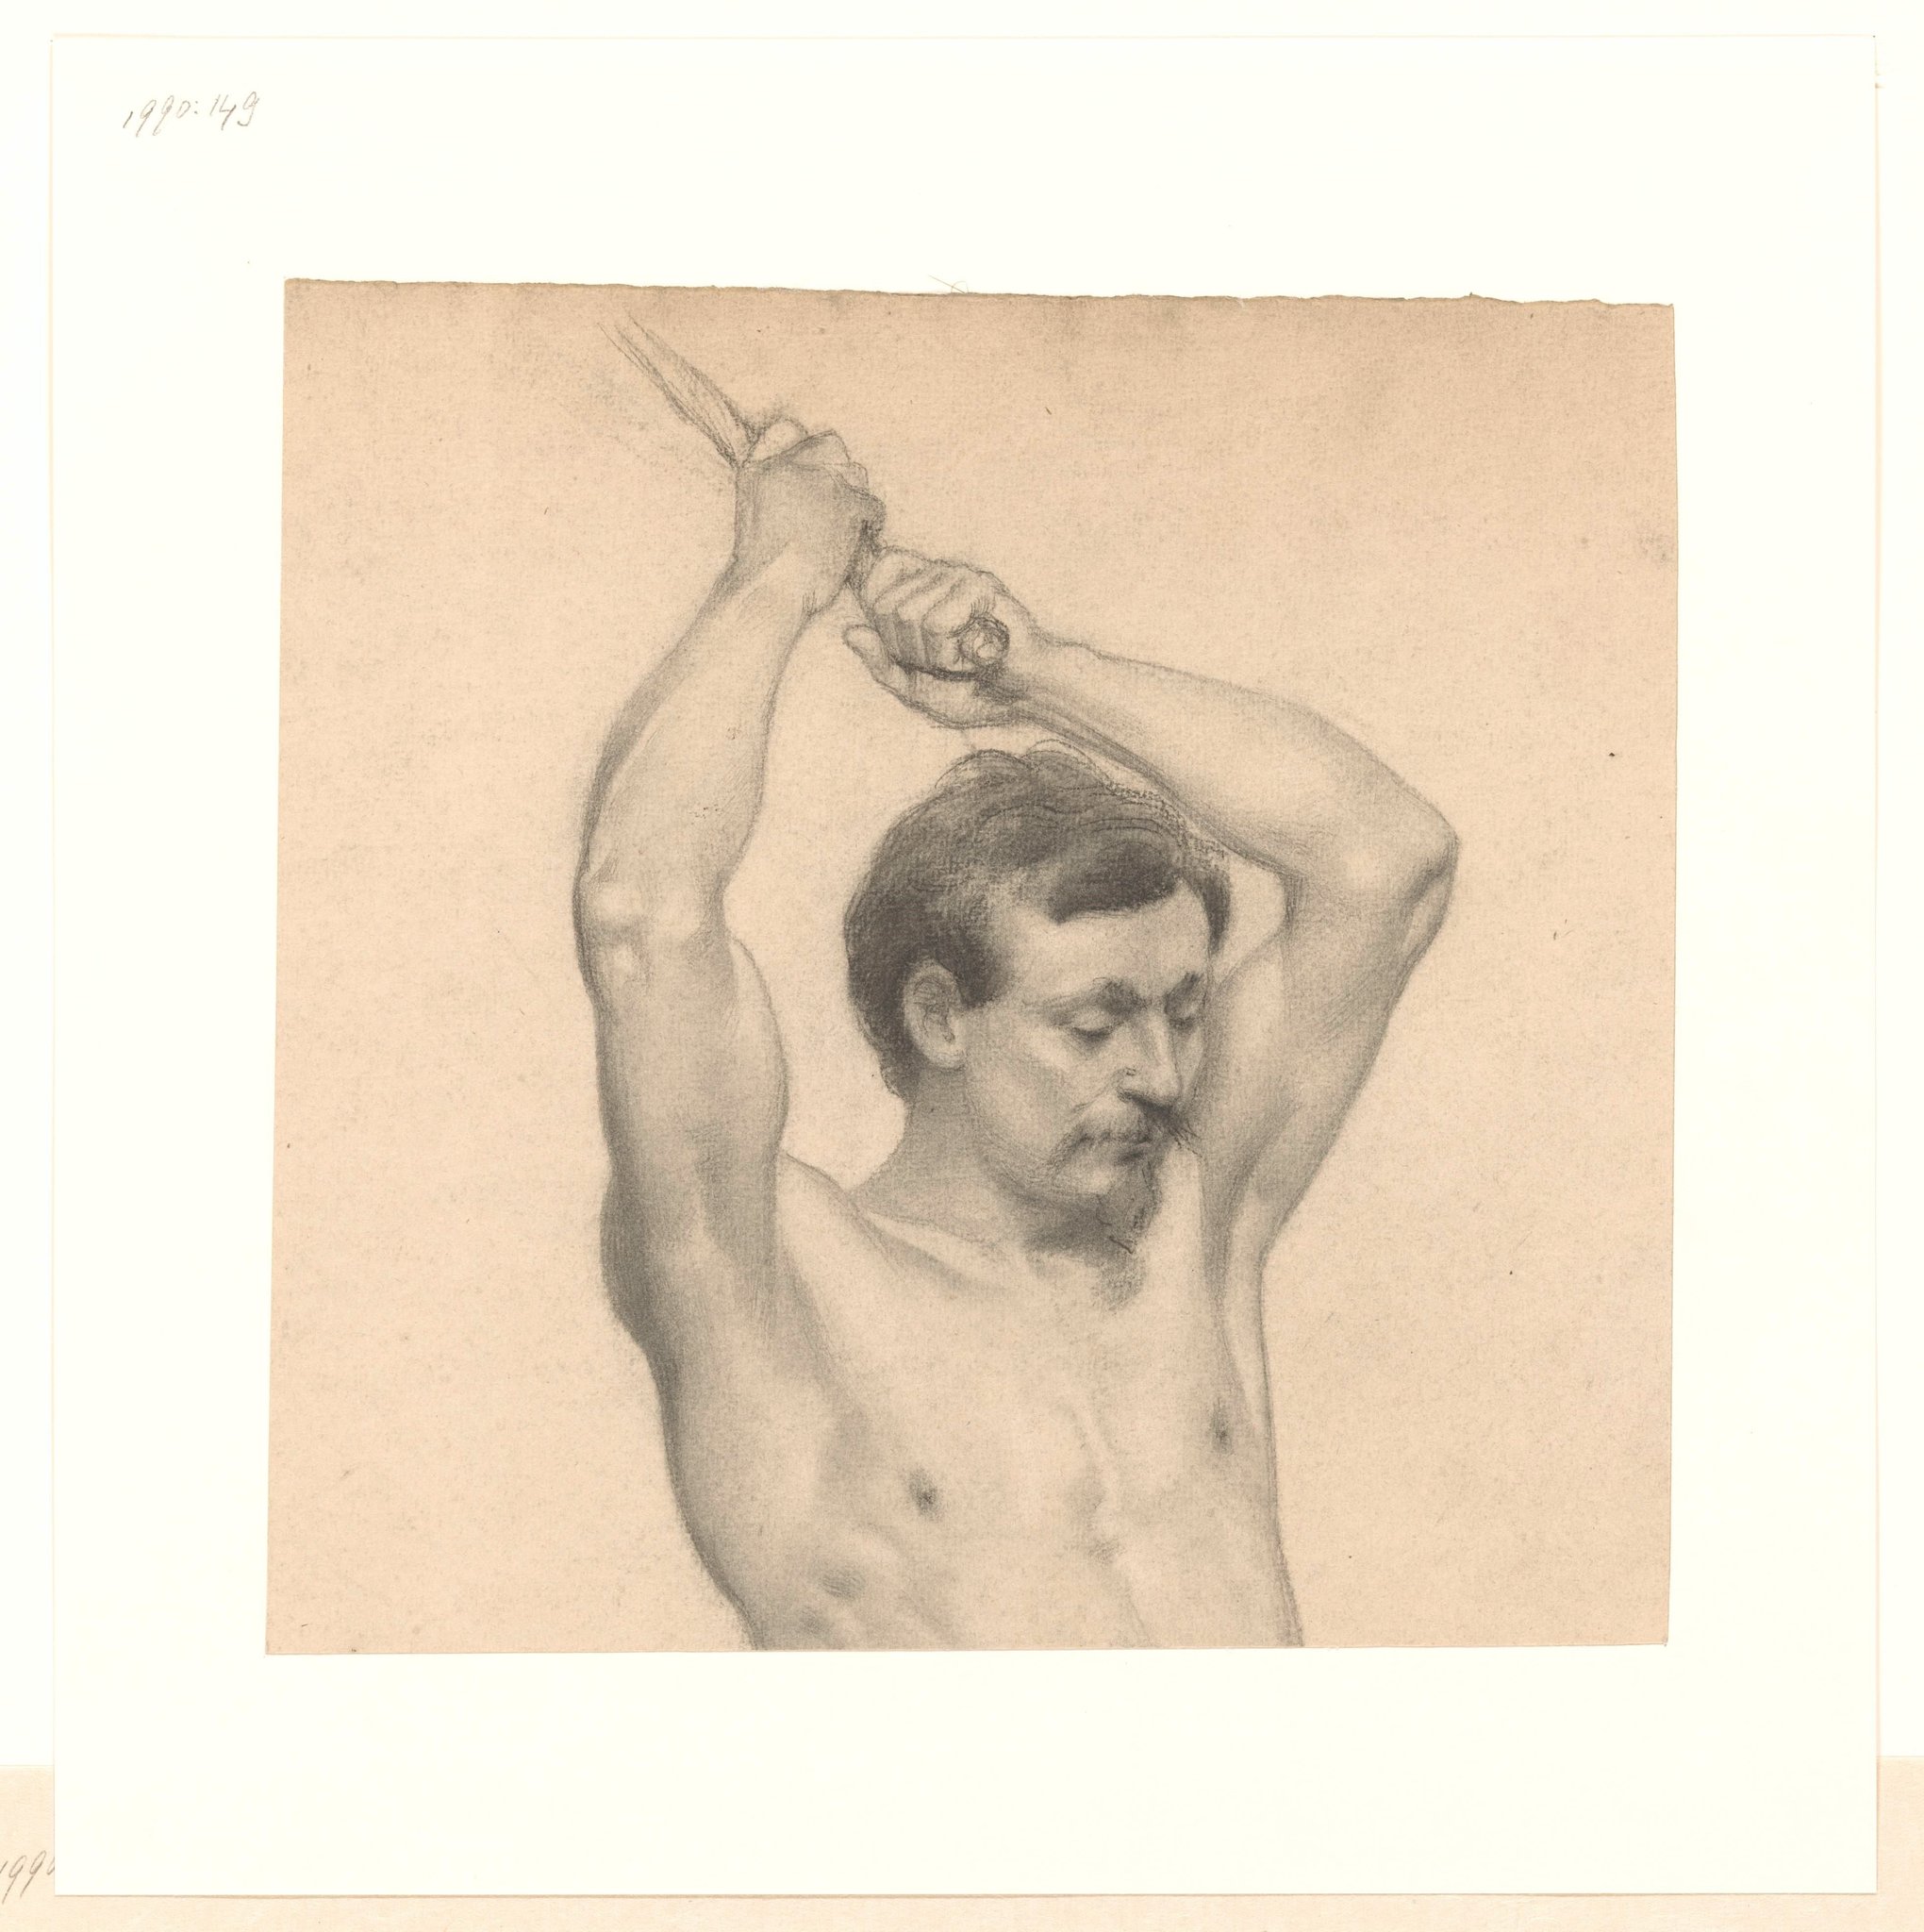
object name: drawing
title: Mannelijk naakt, ten halven lijve, beide armen boven het hoofd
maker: johan braakensiek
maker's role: draughtsman, print maker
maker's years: 1858-1940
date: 1868-1940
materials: chalk, paper